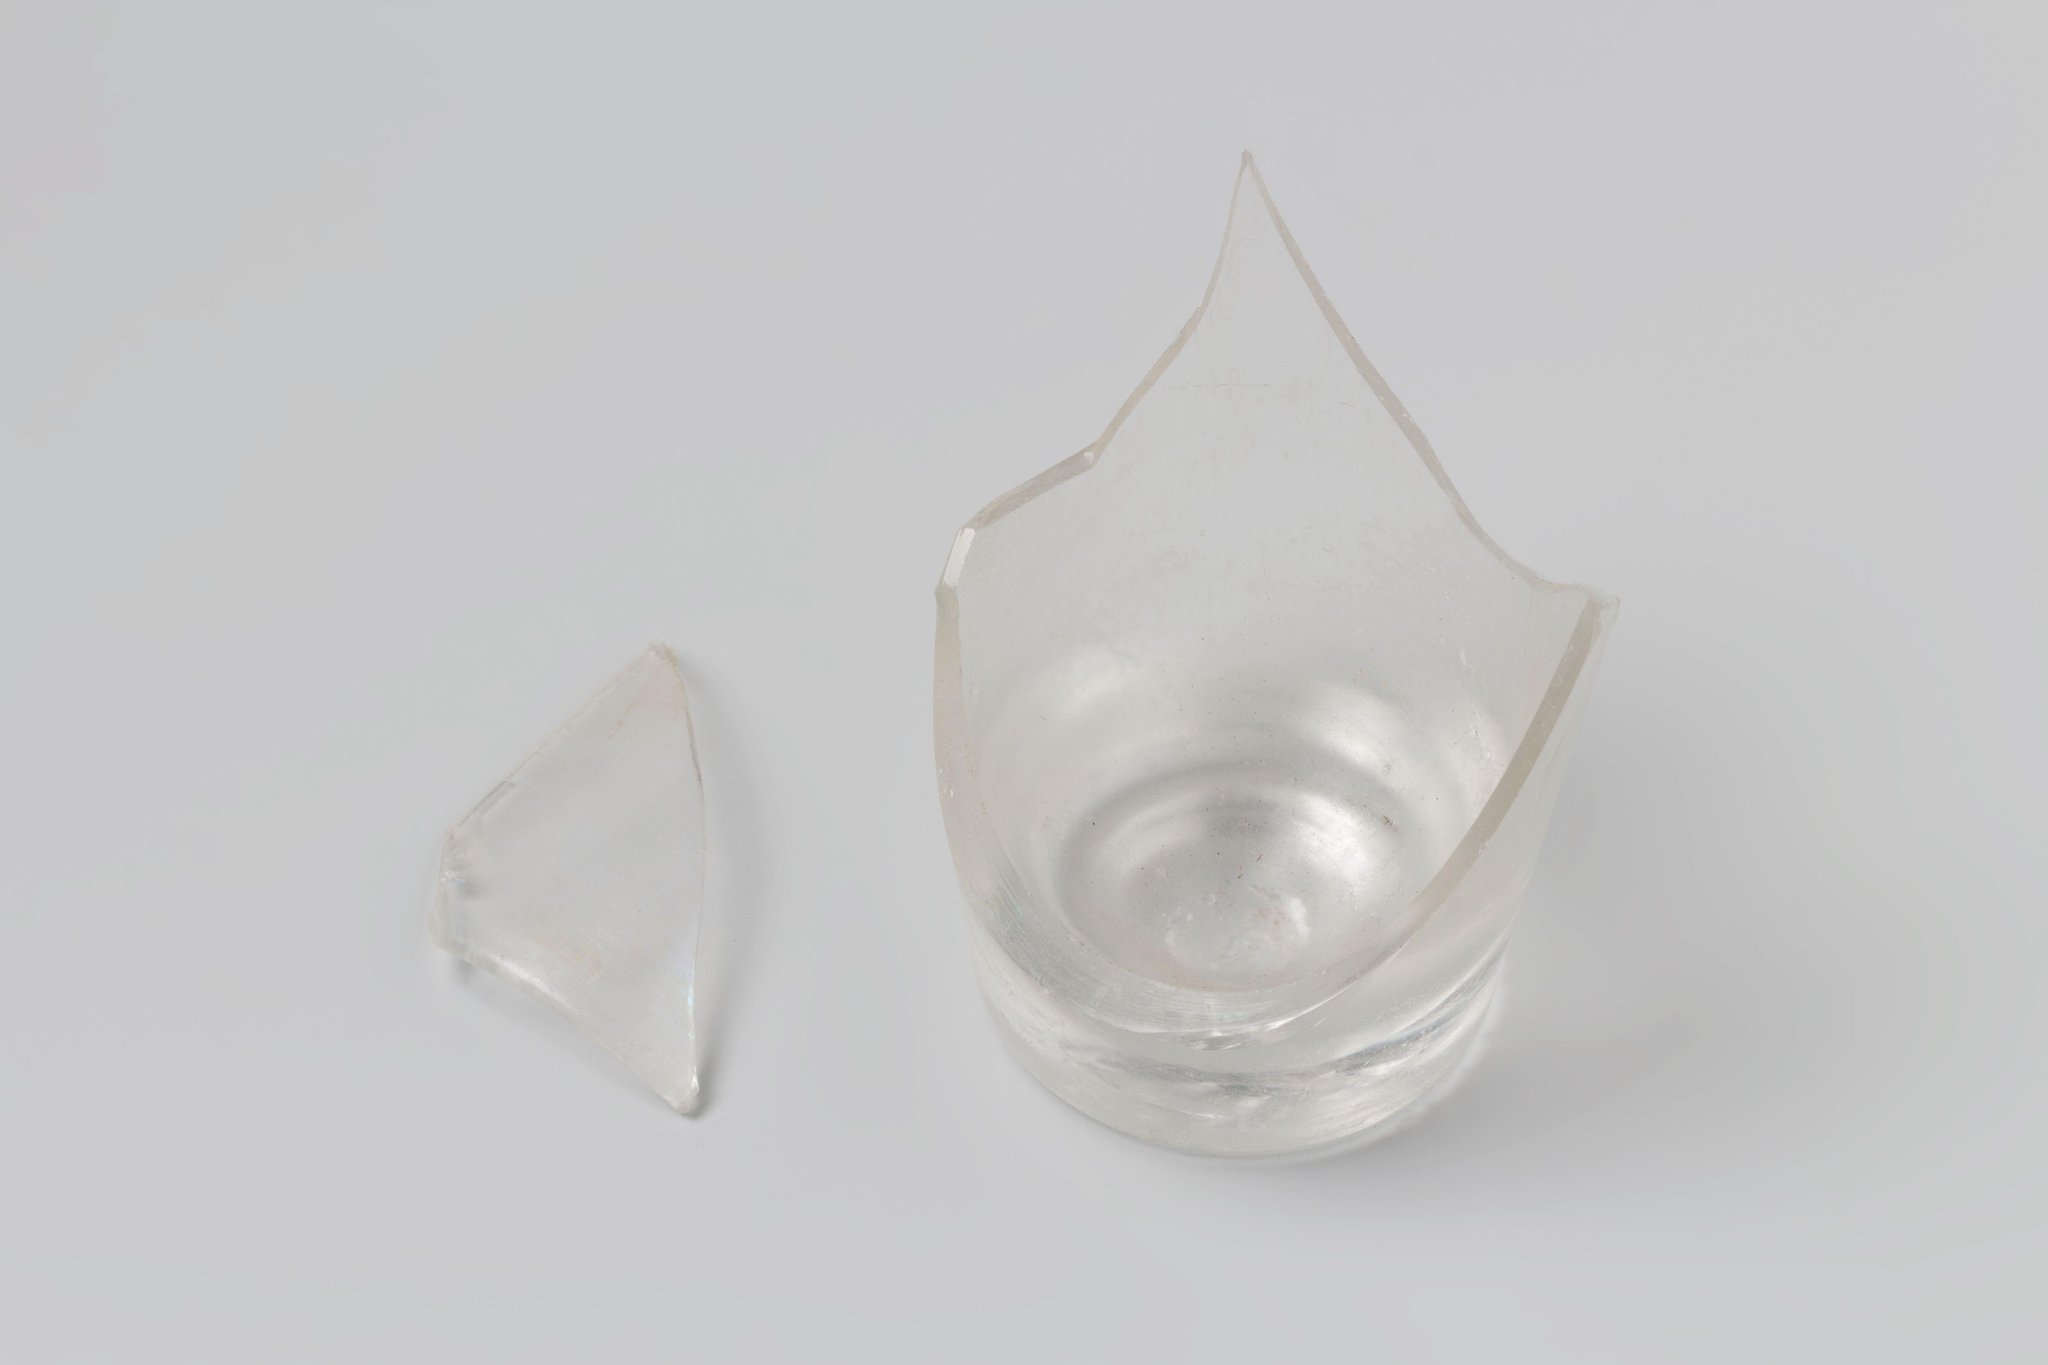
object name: drinking glass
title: Voet van een drinkglas uit het wrak van de Oost-Indiëvaarder 't Vliegend Hart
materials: glass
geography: netherlands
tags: 't vliegend hart (schip), verenigde oostindische compagnie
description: Voet van een rond drinkglas van wit mat glas met opstaande afgebroken punten en éen losse scherf.